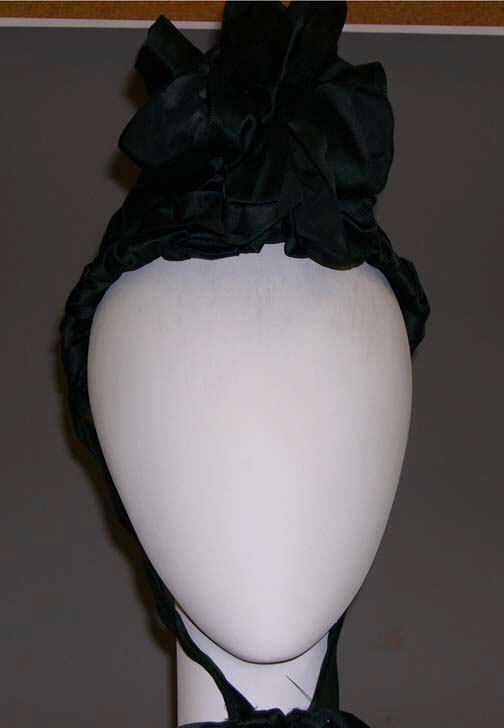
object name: bonnet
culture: french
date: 1880-1890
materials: cotton, silk